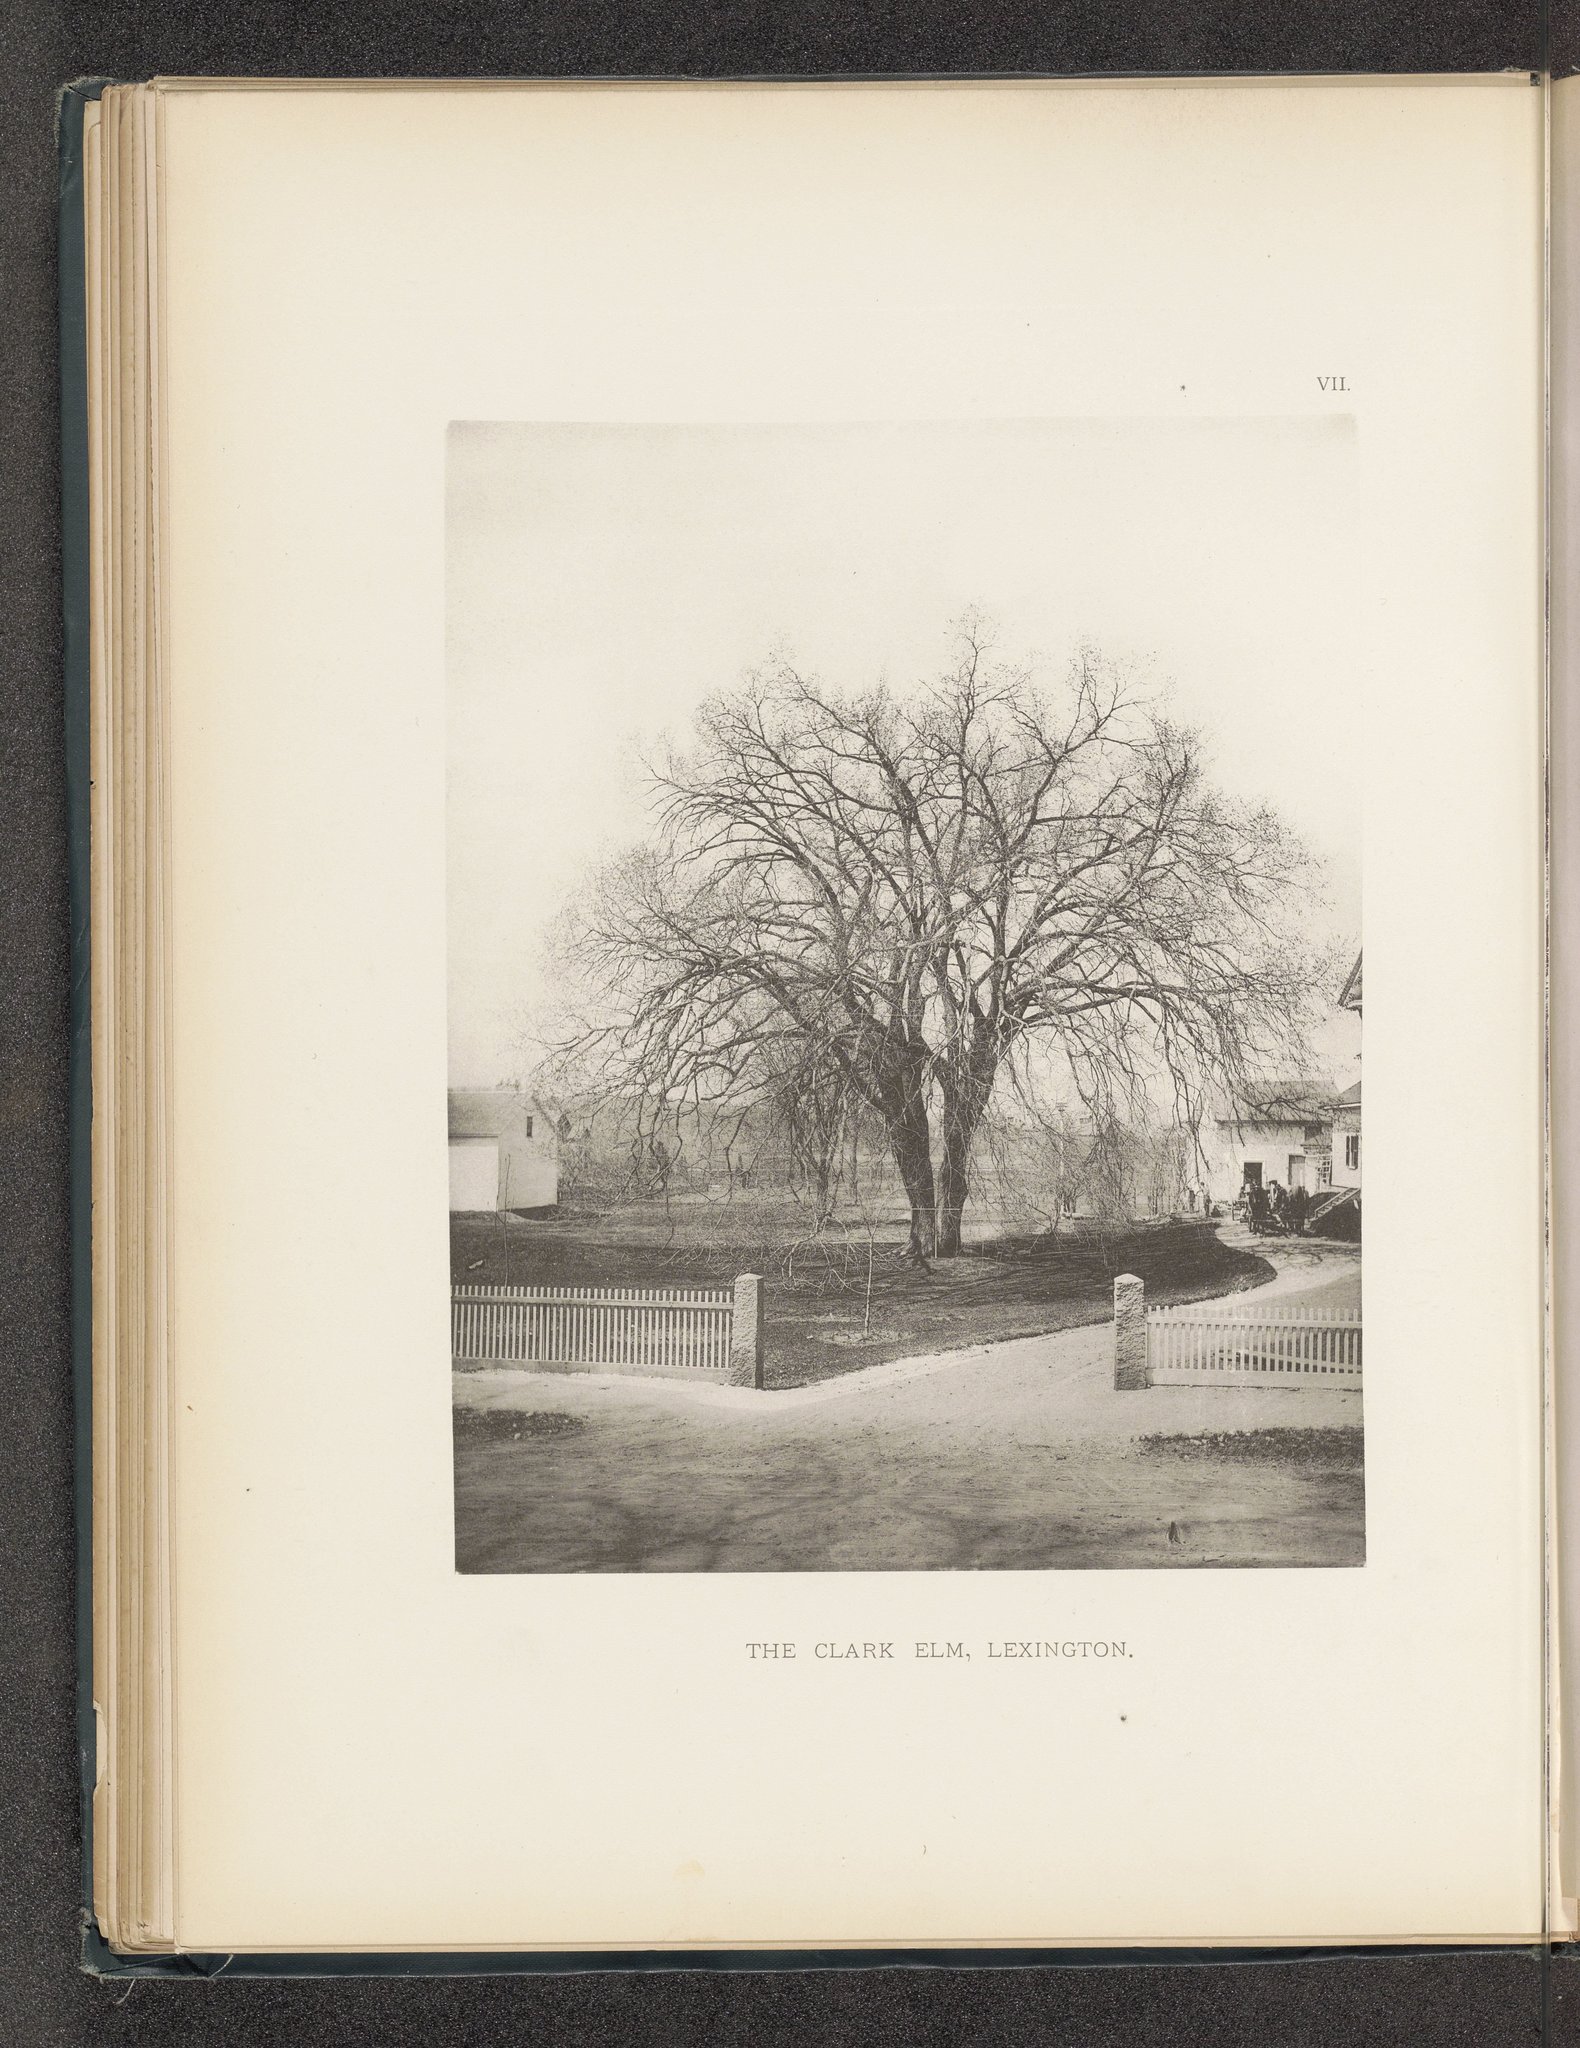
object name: photomechanical print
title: The Clark elm, Lexington, Massachusetts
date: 1880-1890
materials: paper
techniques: photograph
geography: united states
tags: trees: elm, fence, wall, paling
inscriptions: number: ‘VII.’